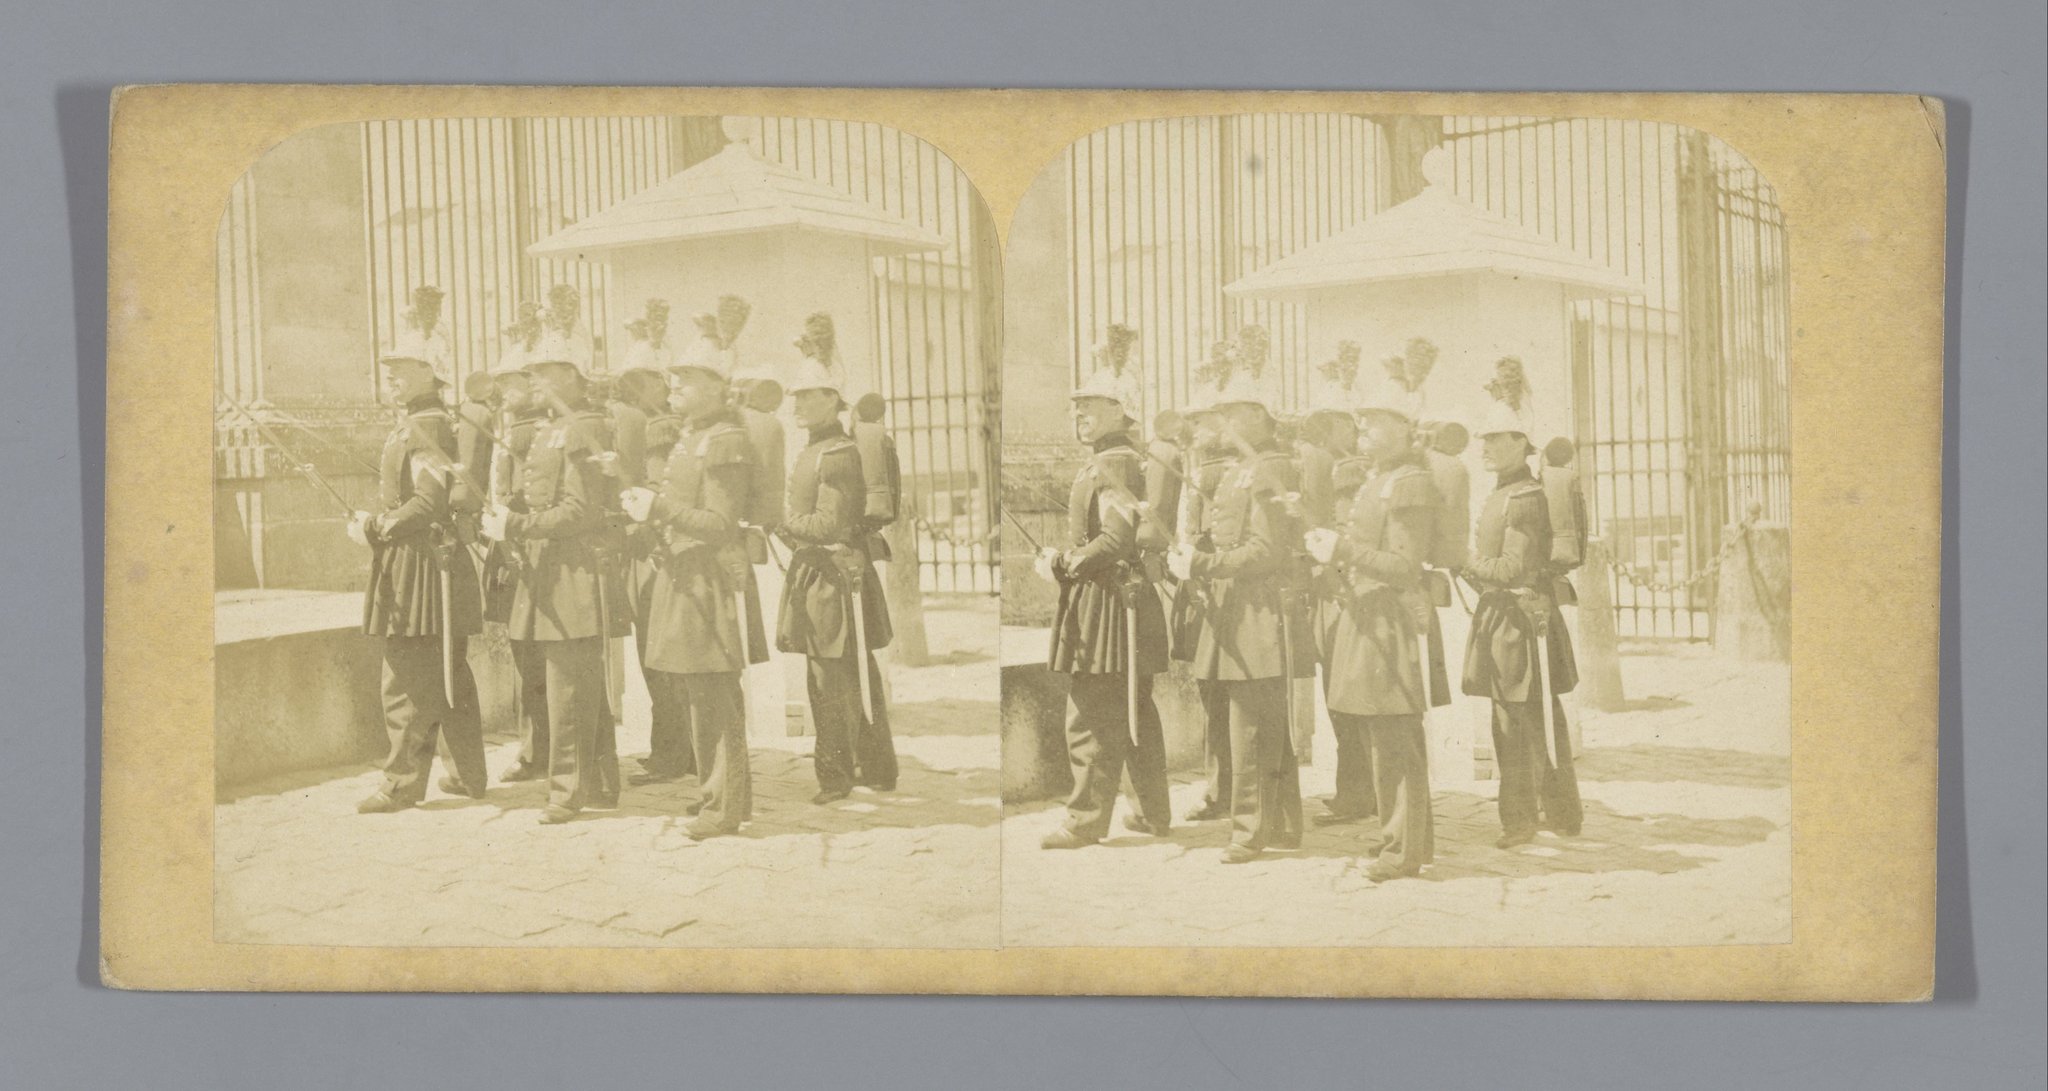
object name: stereograph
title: Militaire wacht voor een hek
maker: Anonymous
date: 1850-1880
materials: cardboard, photographic support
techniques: albumen print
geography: europe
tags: military discipline, fence, wall, paling, europe